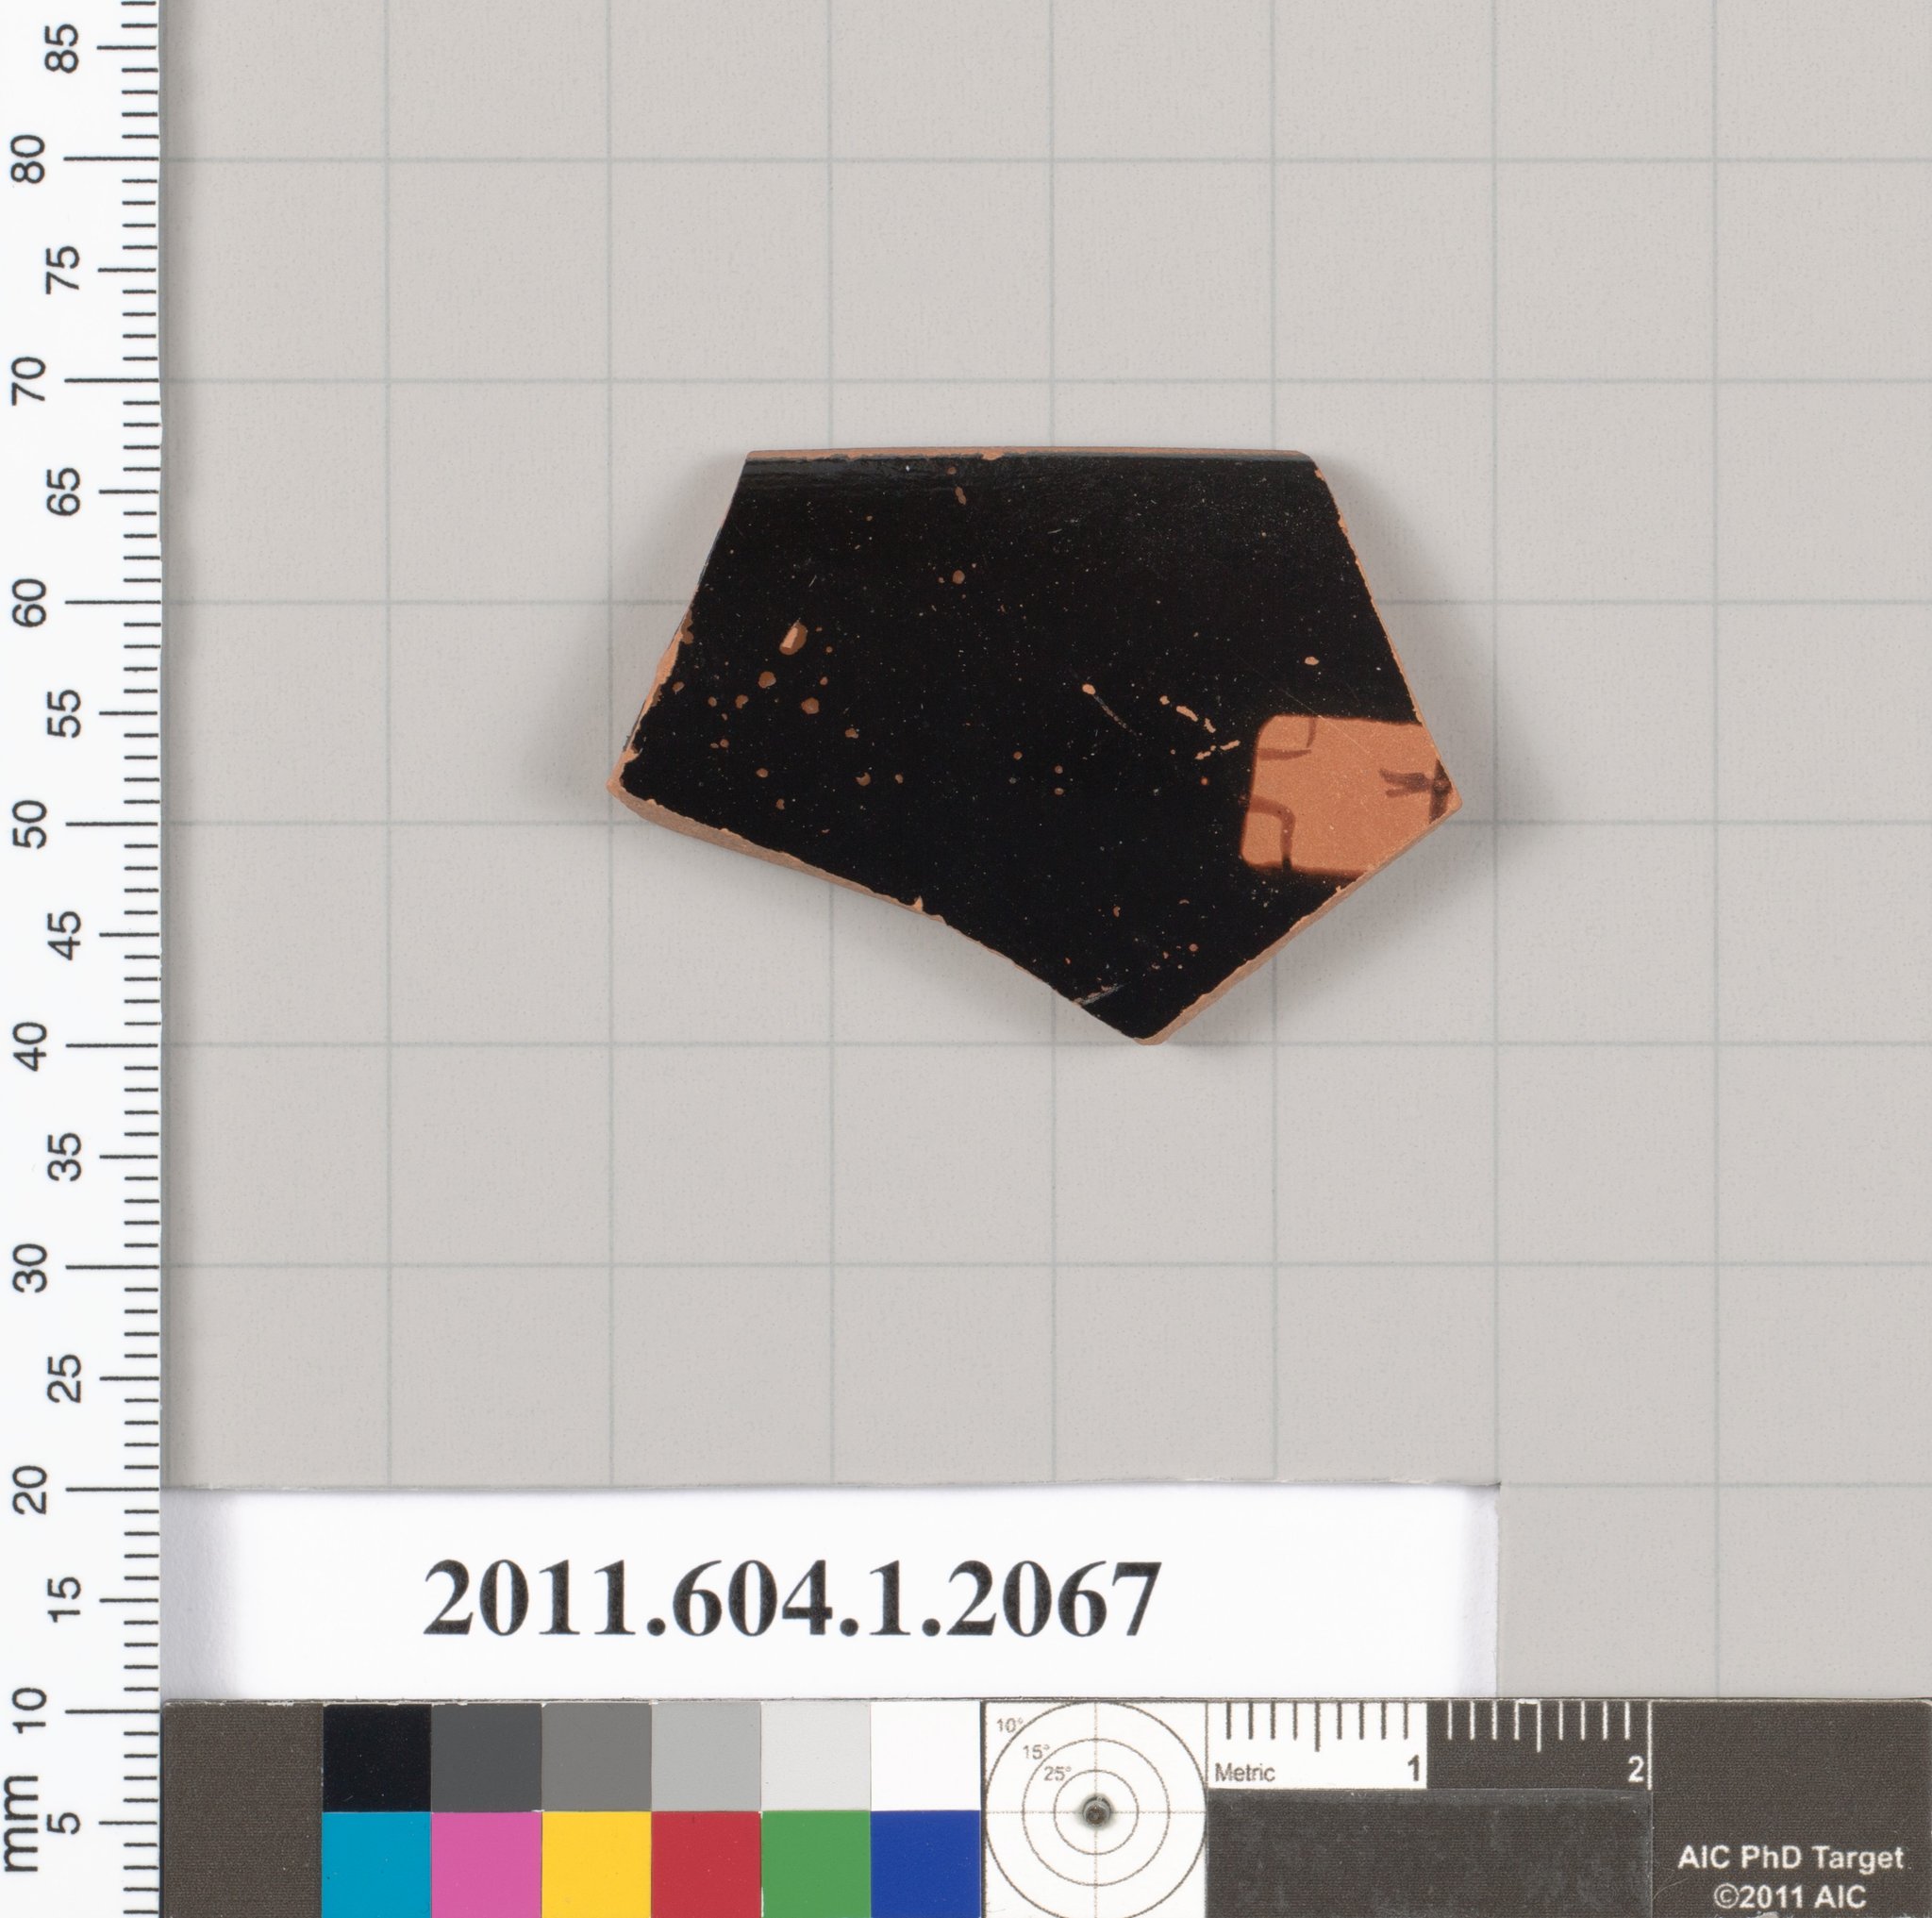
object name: kylix fragment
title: Terracotta rim fragment of a kylix (drinking cup)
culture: greek, attic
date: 475-451 BCE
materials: terracotta